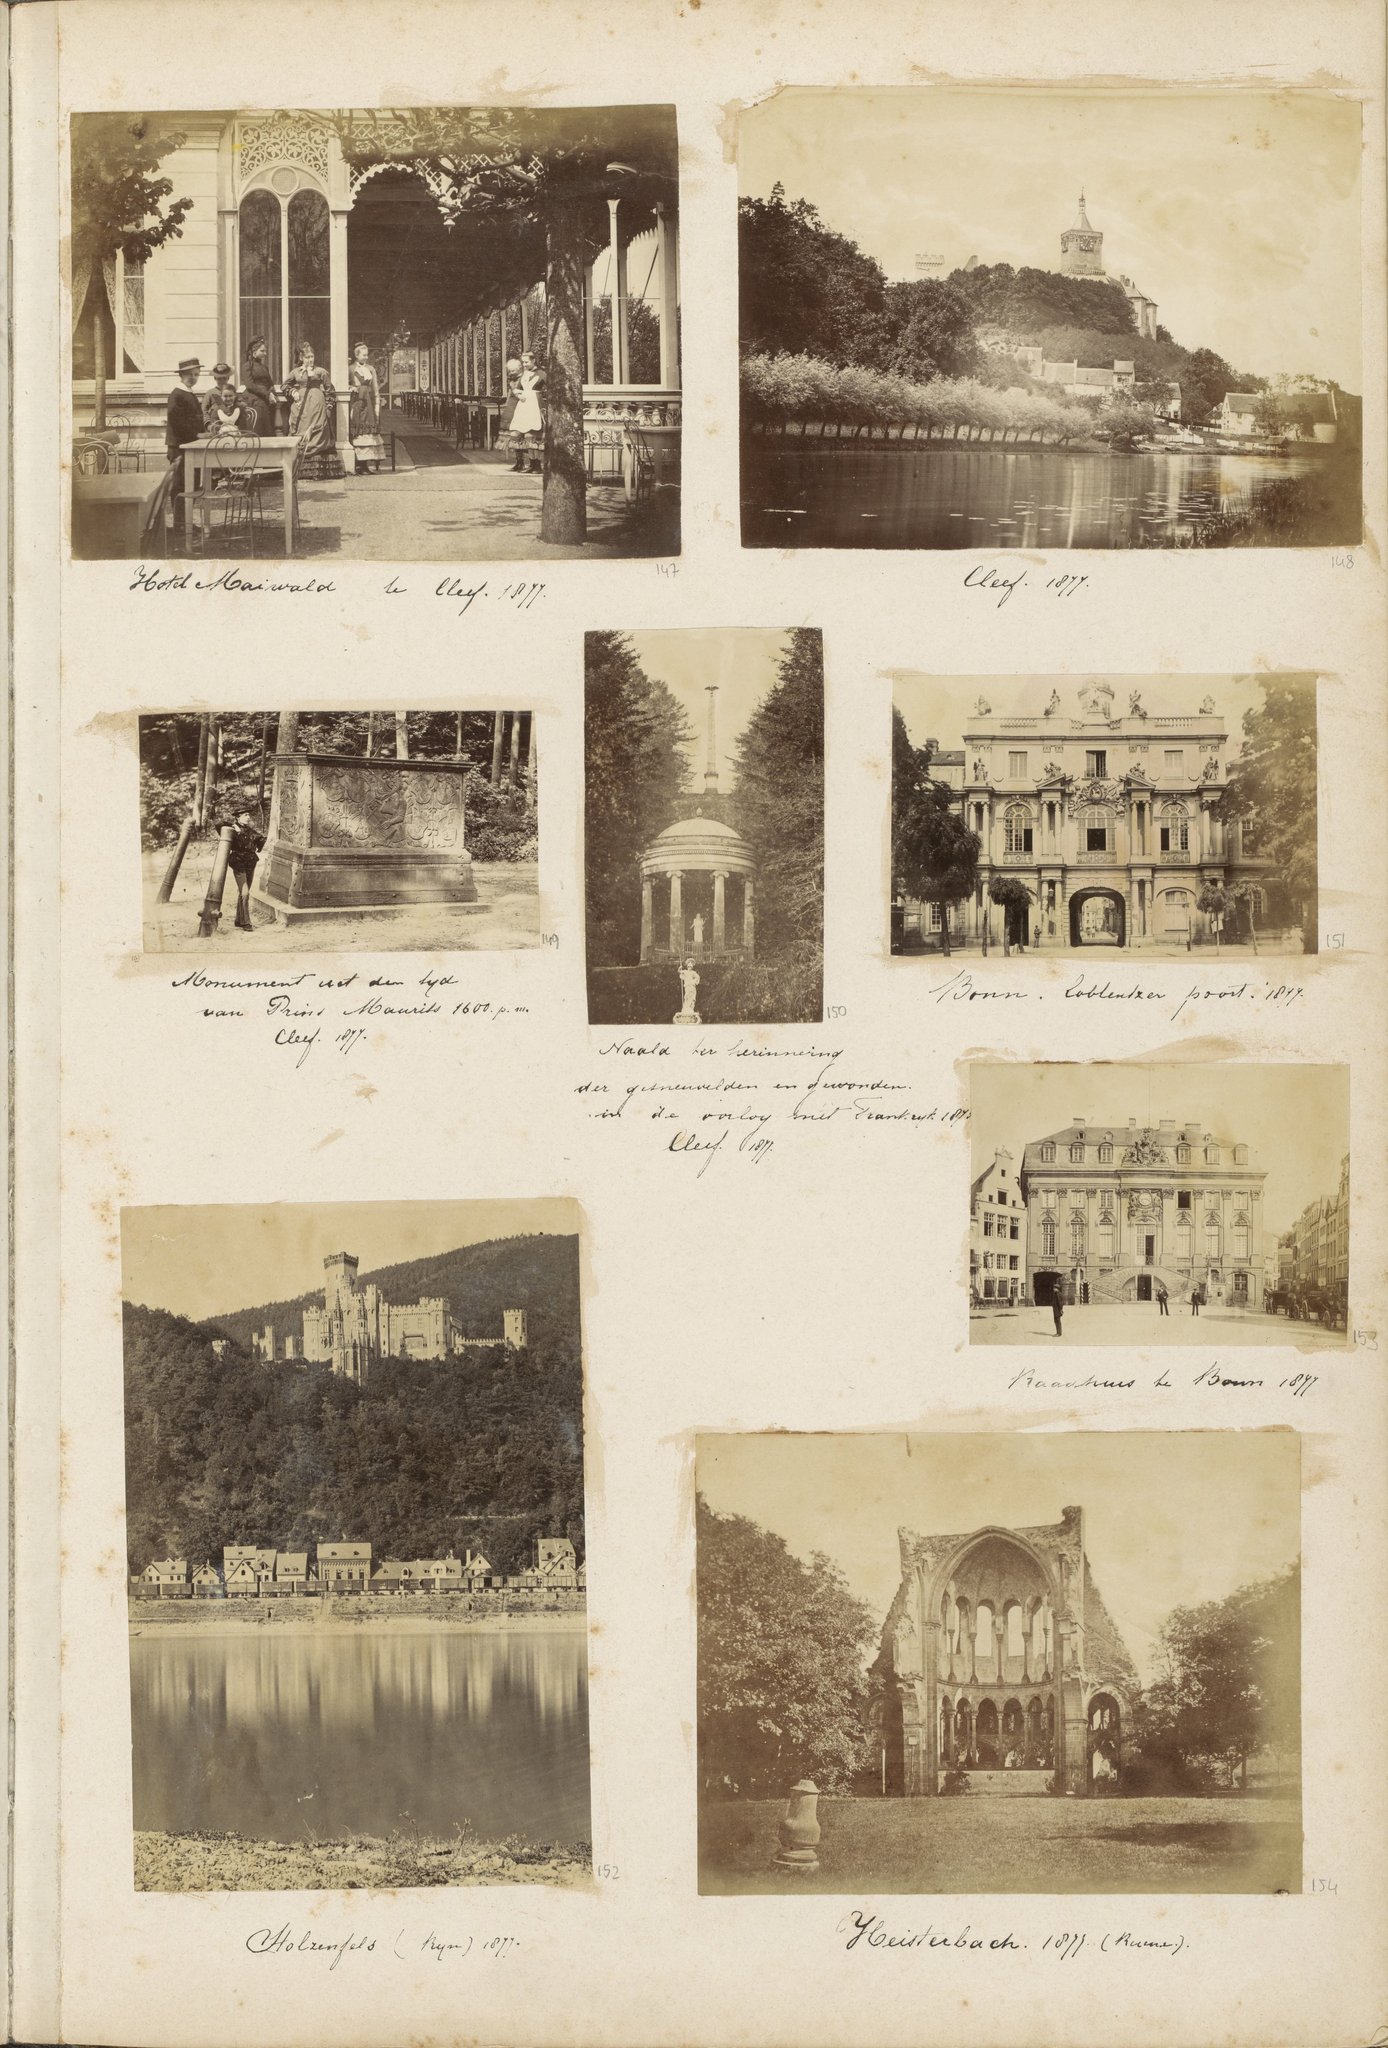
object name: photograph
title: Exterieur van het stadhuis van Bonn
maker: Anonymous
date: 1877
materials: paper, photographic support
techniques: albumen print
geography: bonn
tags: townhall, façade (of house or building)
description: Onderdeel van Fotoalbum van Robert Daniel Crommelin (1841-1907).